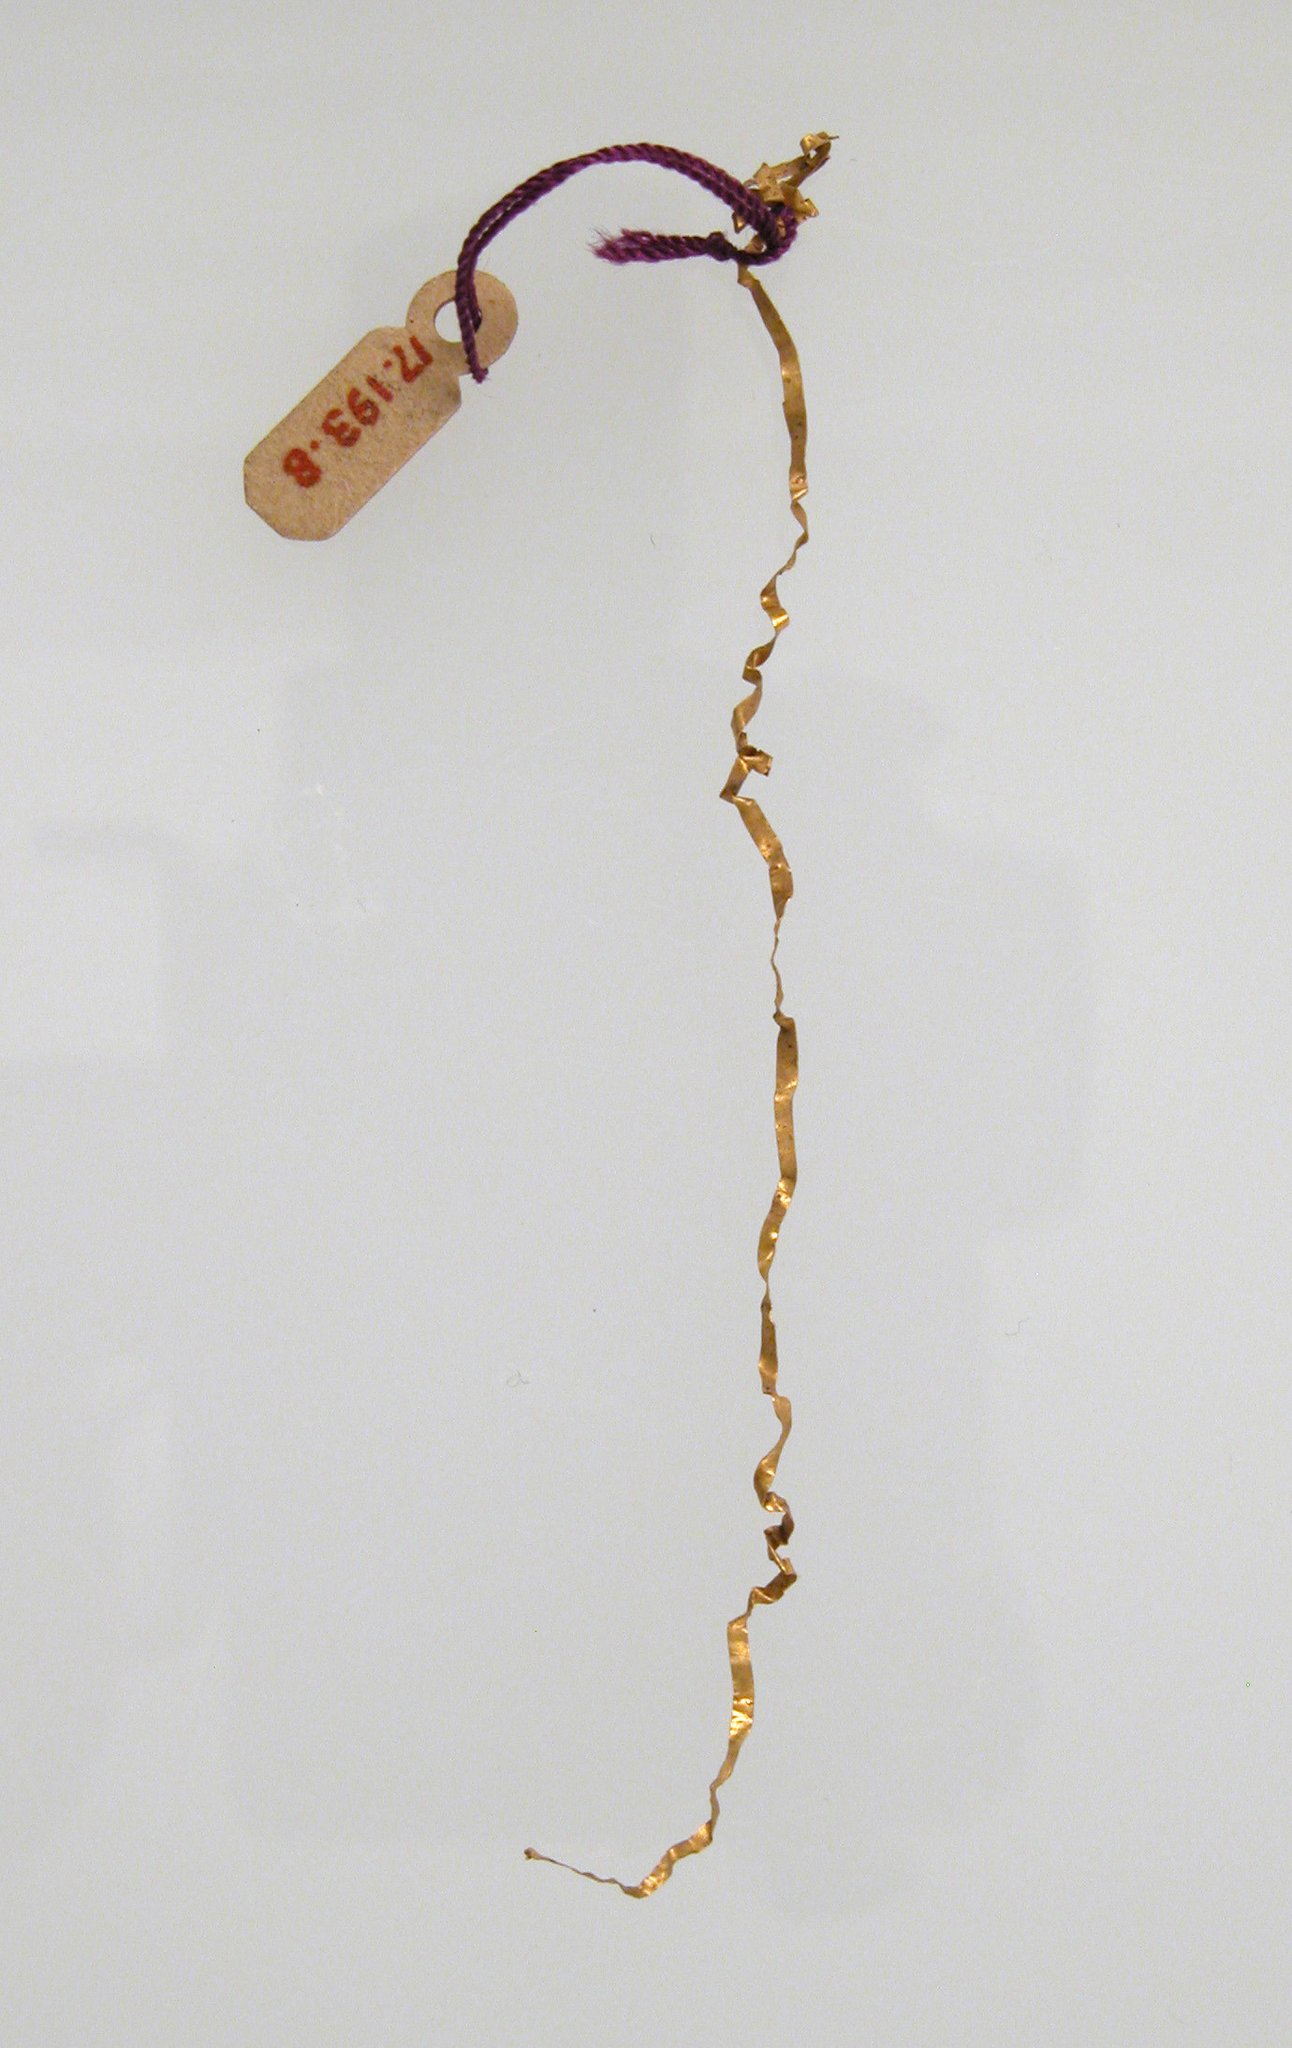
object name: wire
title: Flattened Wire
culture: frankish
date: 601-700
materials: gold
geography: germany